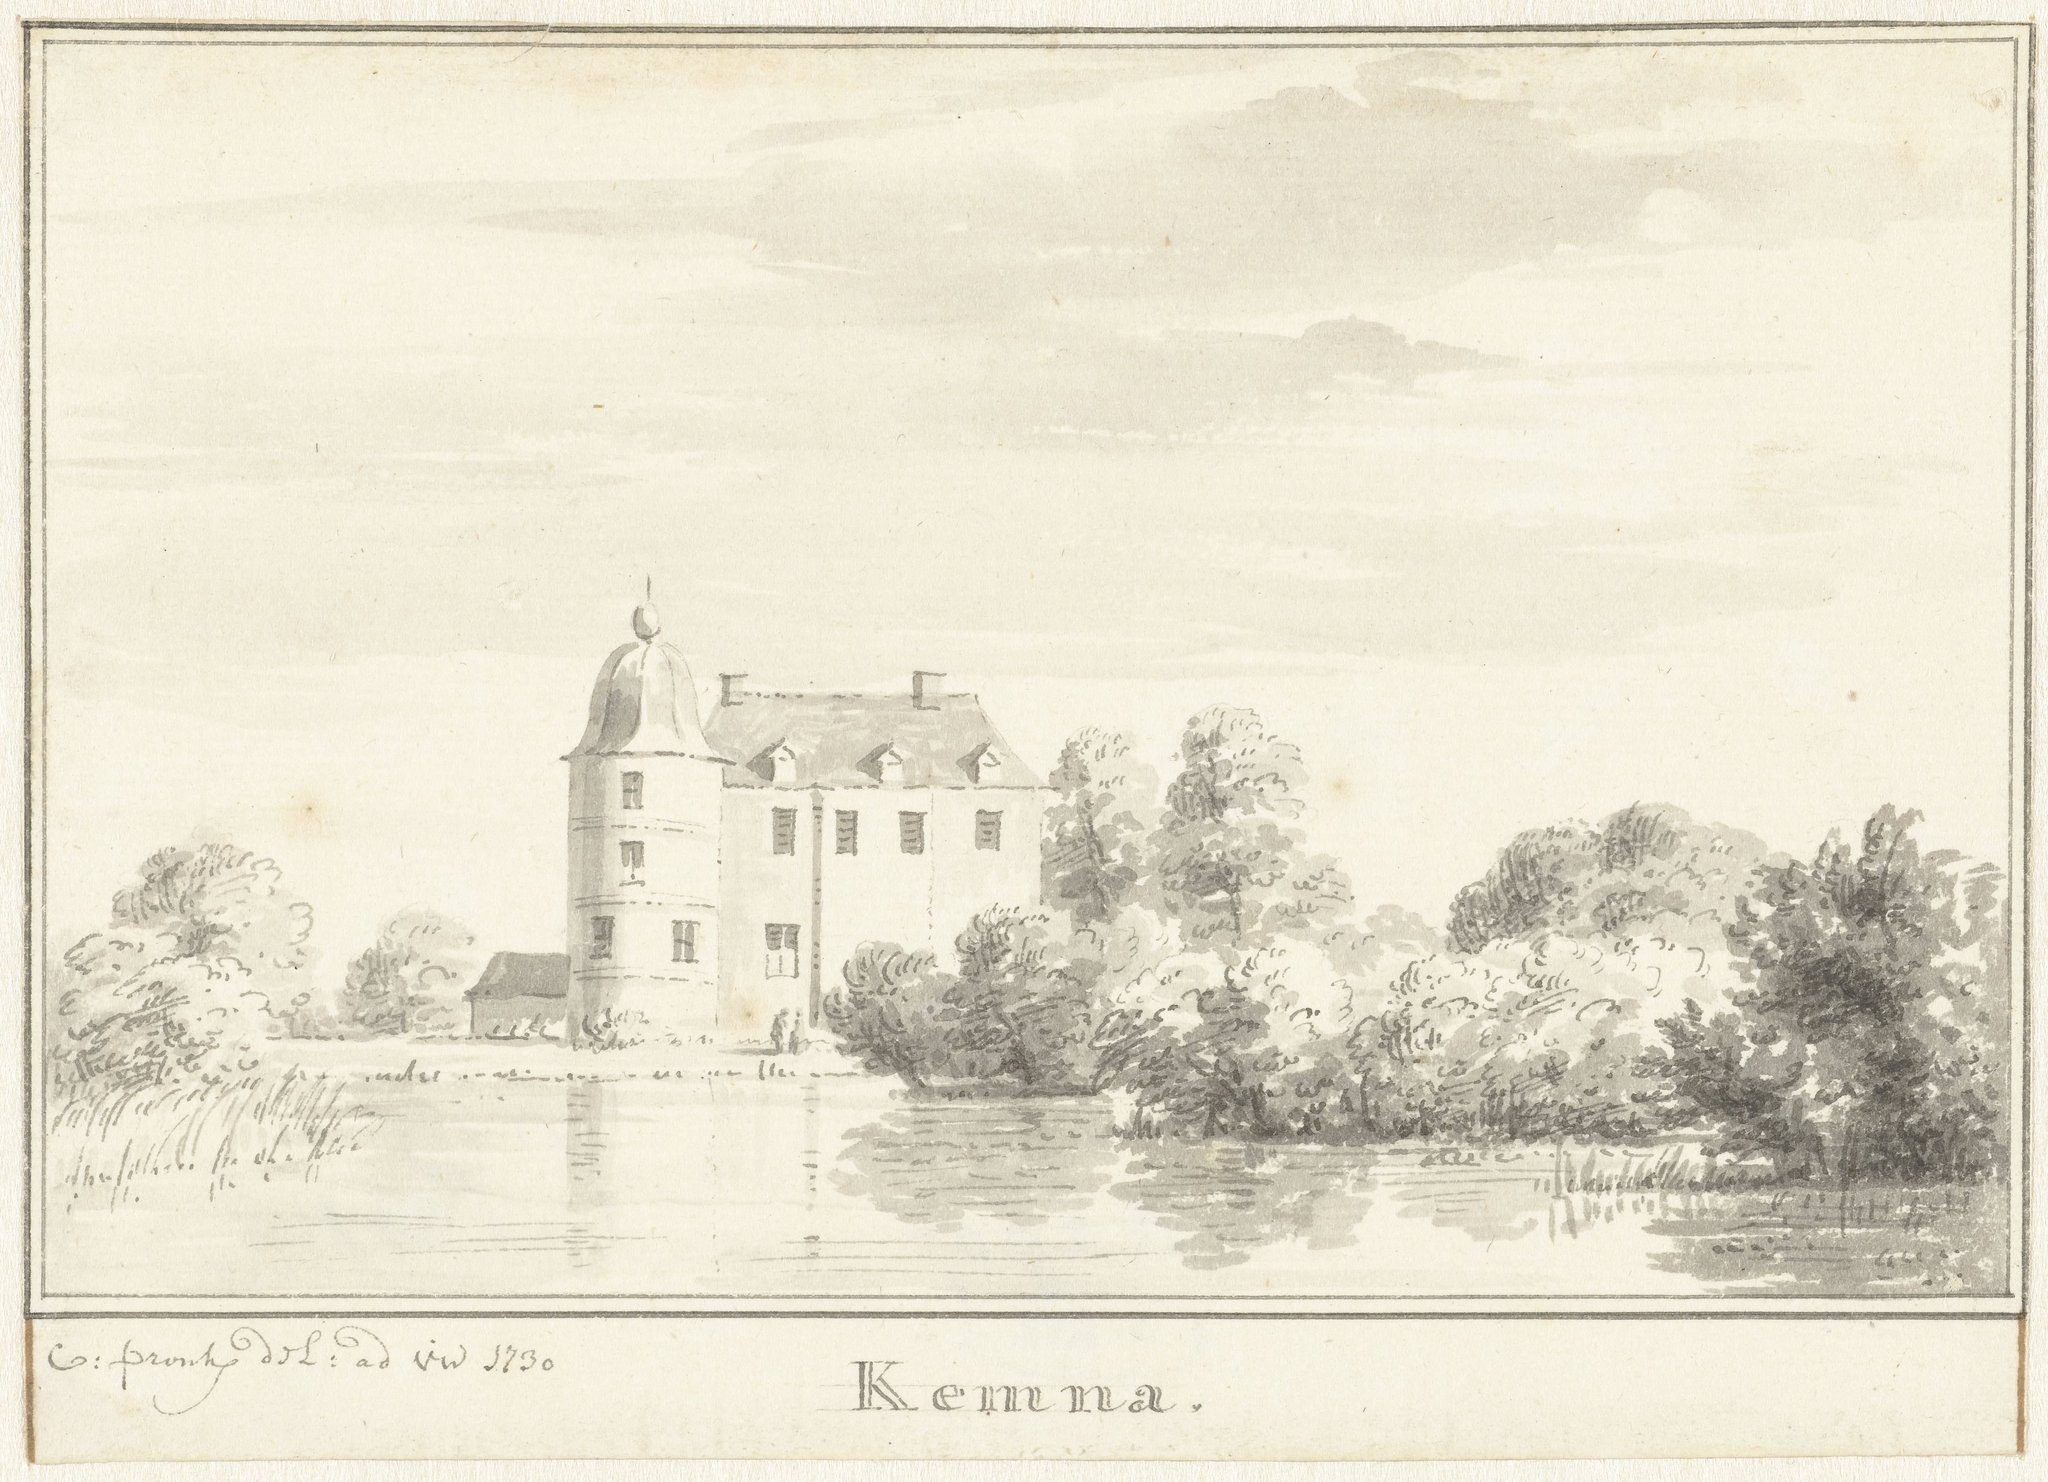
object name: drawing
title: Het huis Kemna aan de Oude IJssel, Gelderland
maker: cornelis pronk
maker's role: draughtsman, painter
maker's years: 1691-1759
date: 1730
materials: ink, paper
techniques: brush, pen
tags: castle, rural housing, e.g. country-house, villa, cottage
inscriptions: inscription: ‘Onder: C: Pronk del: ad viv 1730 / Kemna’